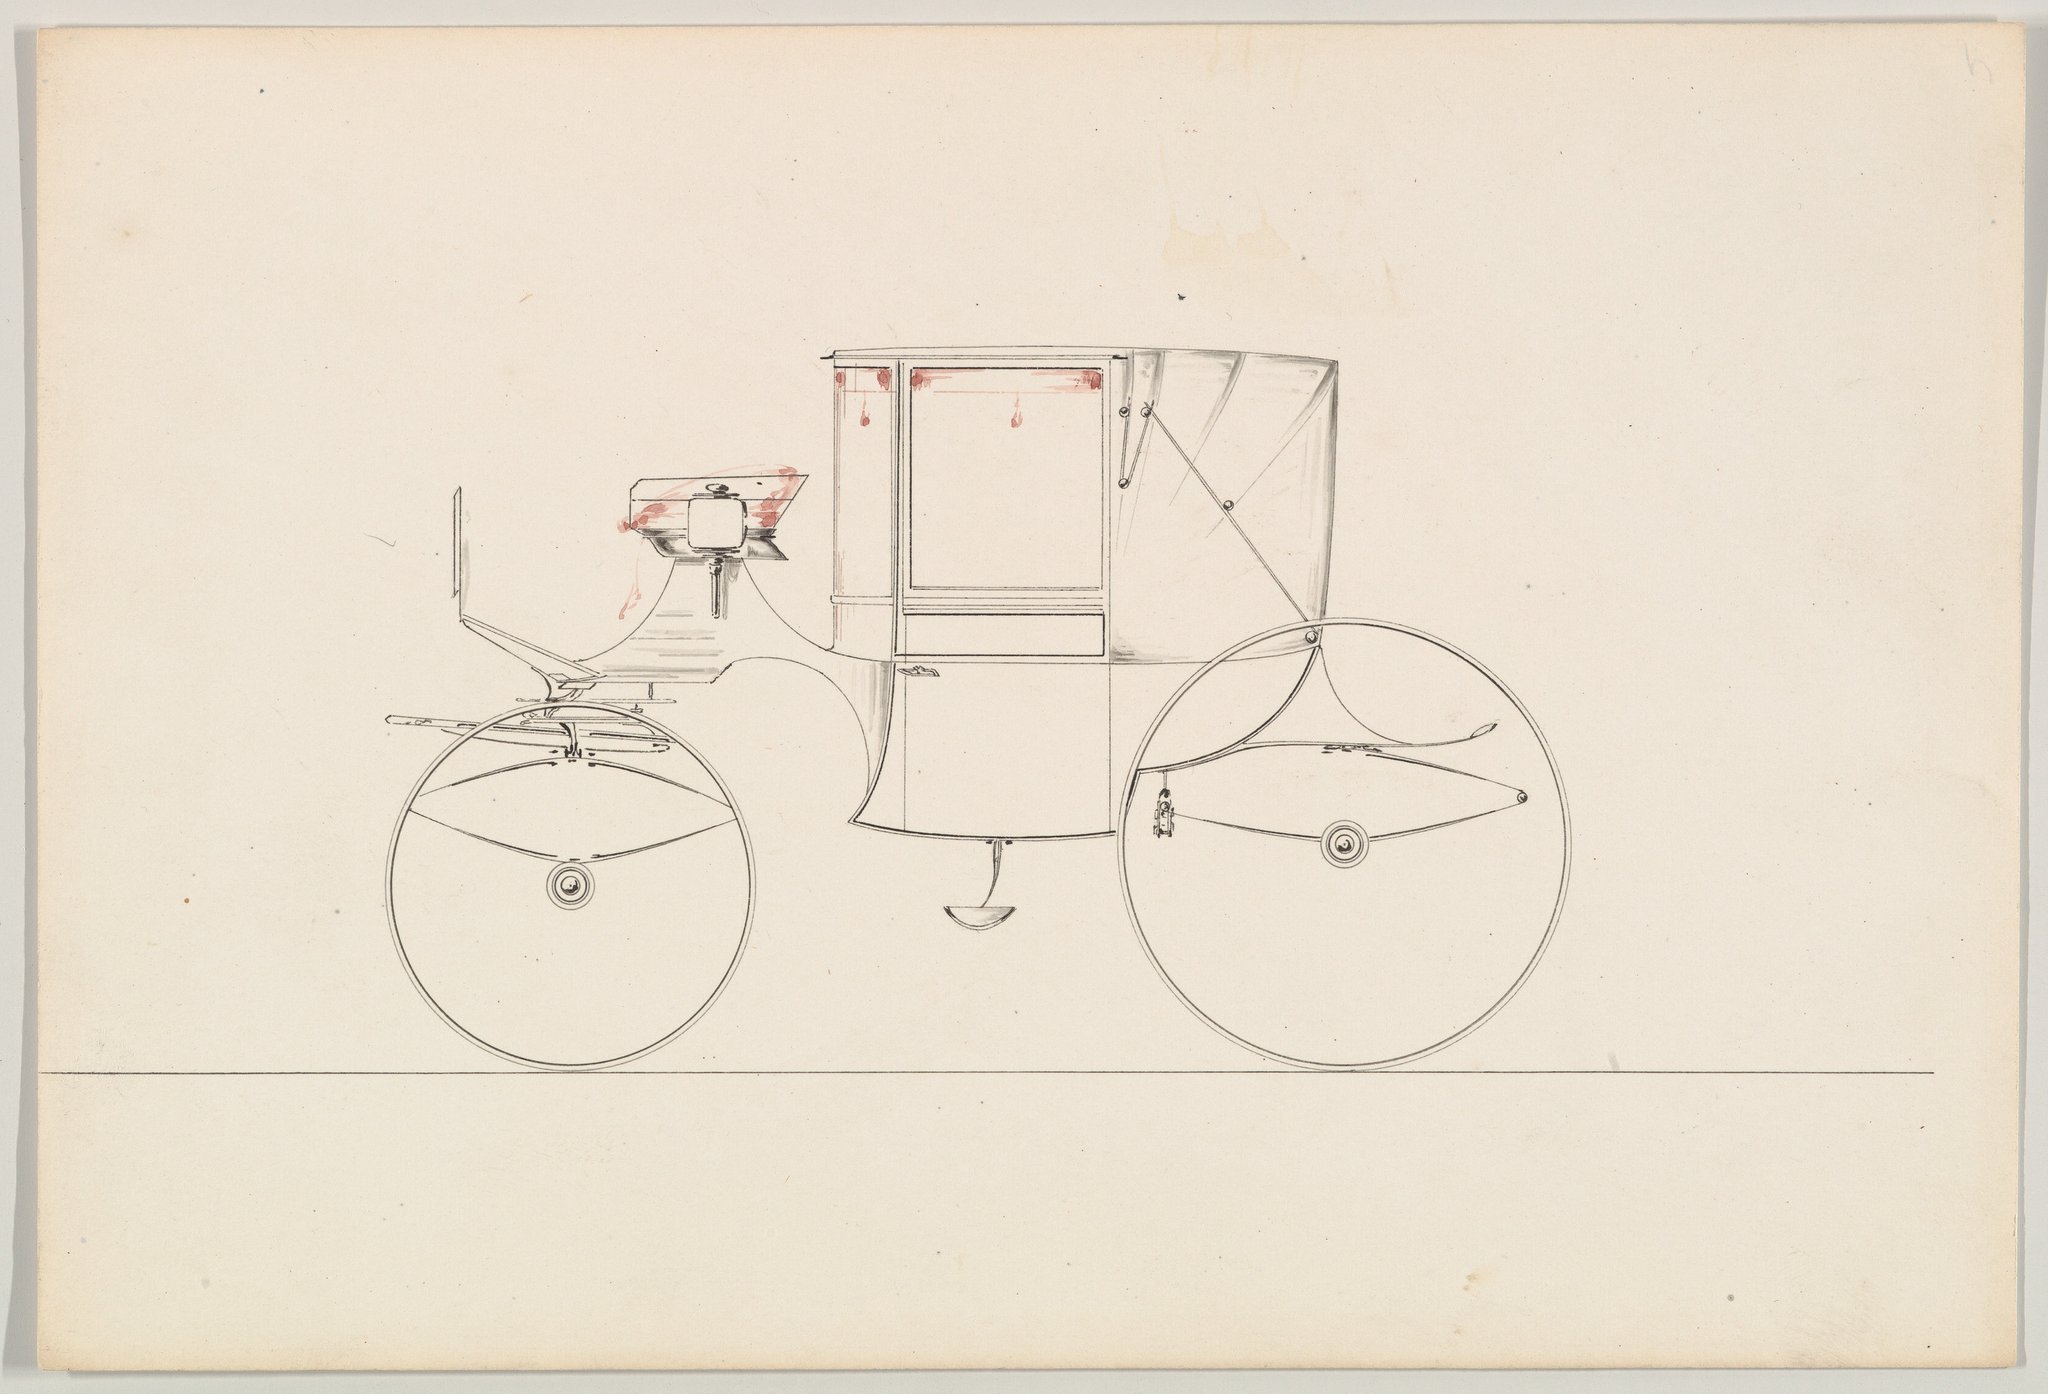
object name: drawing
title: Design for Bow Front Landaulet (unnumbered)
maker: brewster & co.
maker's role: manufacturer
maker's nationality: american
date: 1850-1870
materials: gouache, ink, watercolor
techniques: pen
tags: carriages